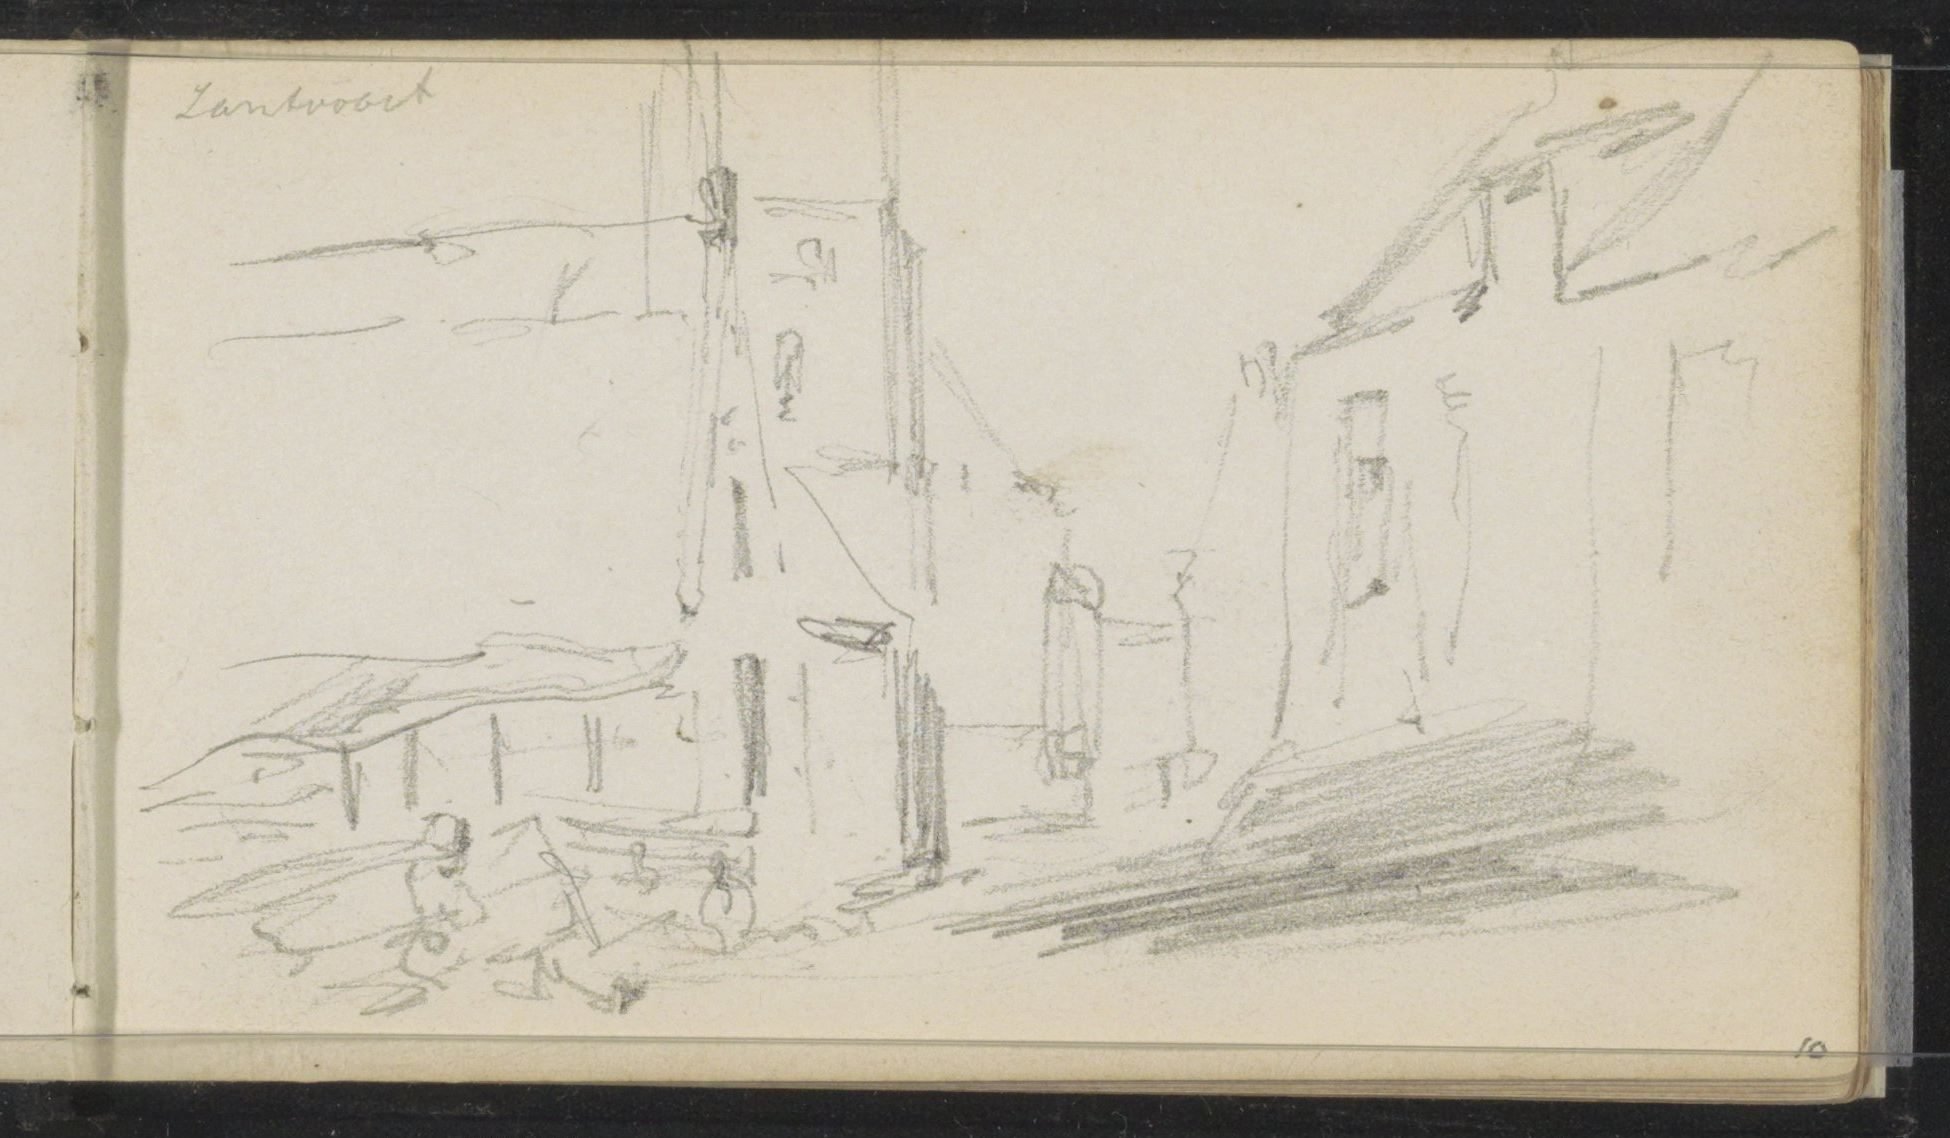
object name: sketchbook leaf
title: Gezicht in Zandvoort met de dorpskerk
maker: cornelis springer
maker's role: draughtsman, painter, print maker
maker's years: 1817-1891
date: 1860-1866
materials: paper, pencil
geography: netherlands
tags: urban housing, church (exterior), street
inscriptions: annotation: ‘Zantvoort’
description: Gezicht op een straat in Zandvoort met de dorpskerk. Blad 10 recto uit een schetsboek met 44 bladen.